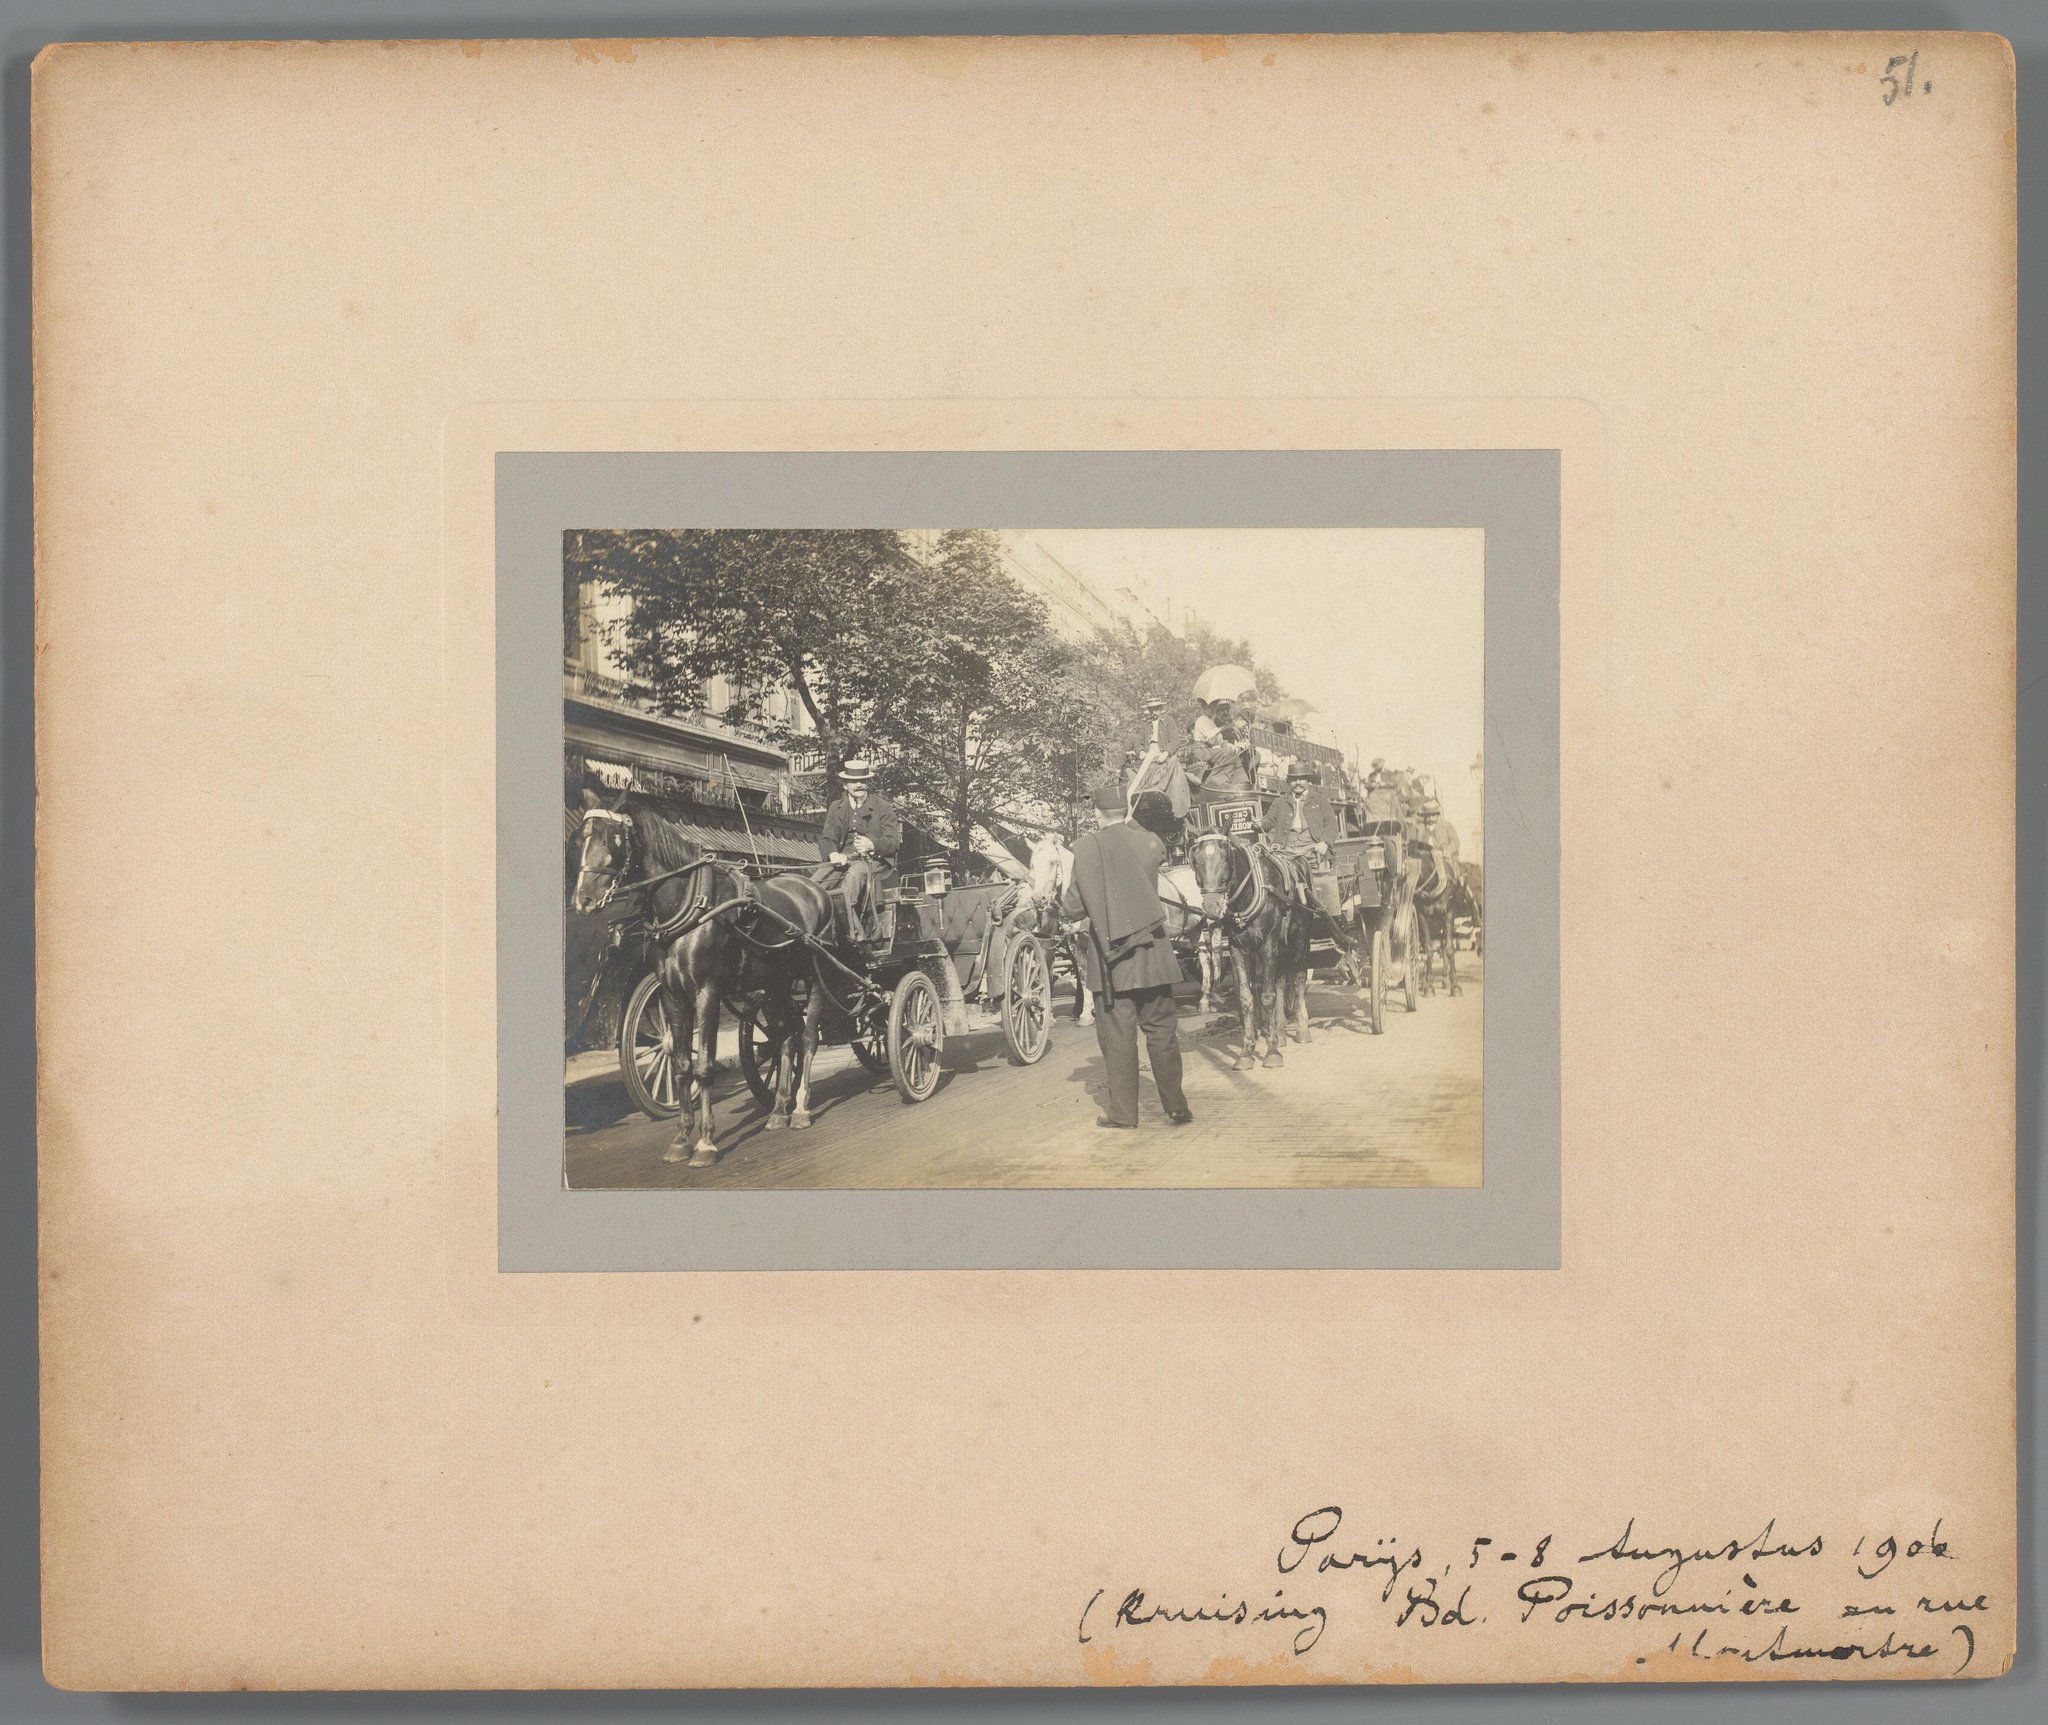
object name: photograph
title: Parijs (Kruising Bd. Poissonnière en rue Montmartre)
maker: françois buys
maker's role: advocaat, amateurfotograaf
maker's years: 1871-1934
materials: paper, cardboard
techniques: gelatin silver print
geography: paris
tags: four-wheeled vehicle drawn by one animal, policeman, constable, street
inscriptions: number: ‘51’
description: Deze foto maakt deel uit van een groep van 49 foto's.